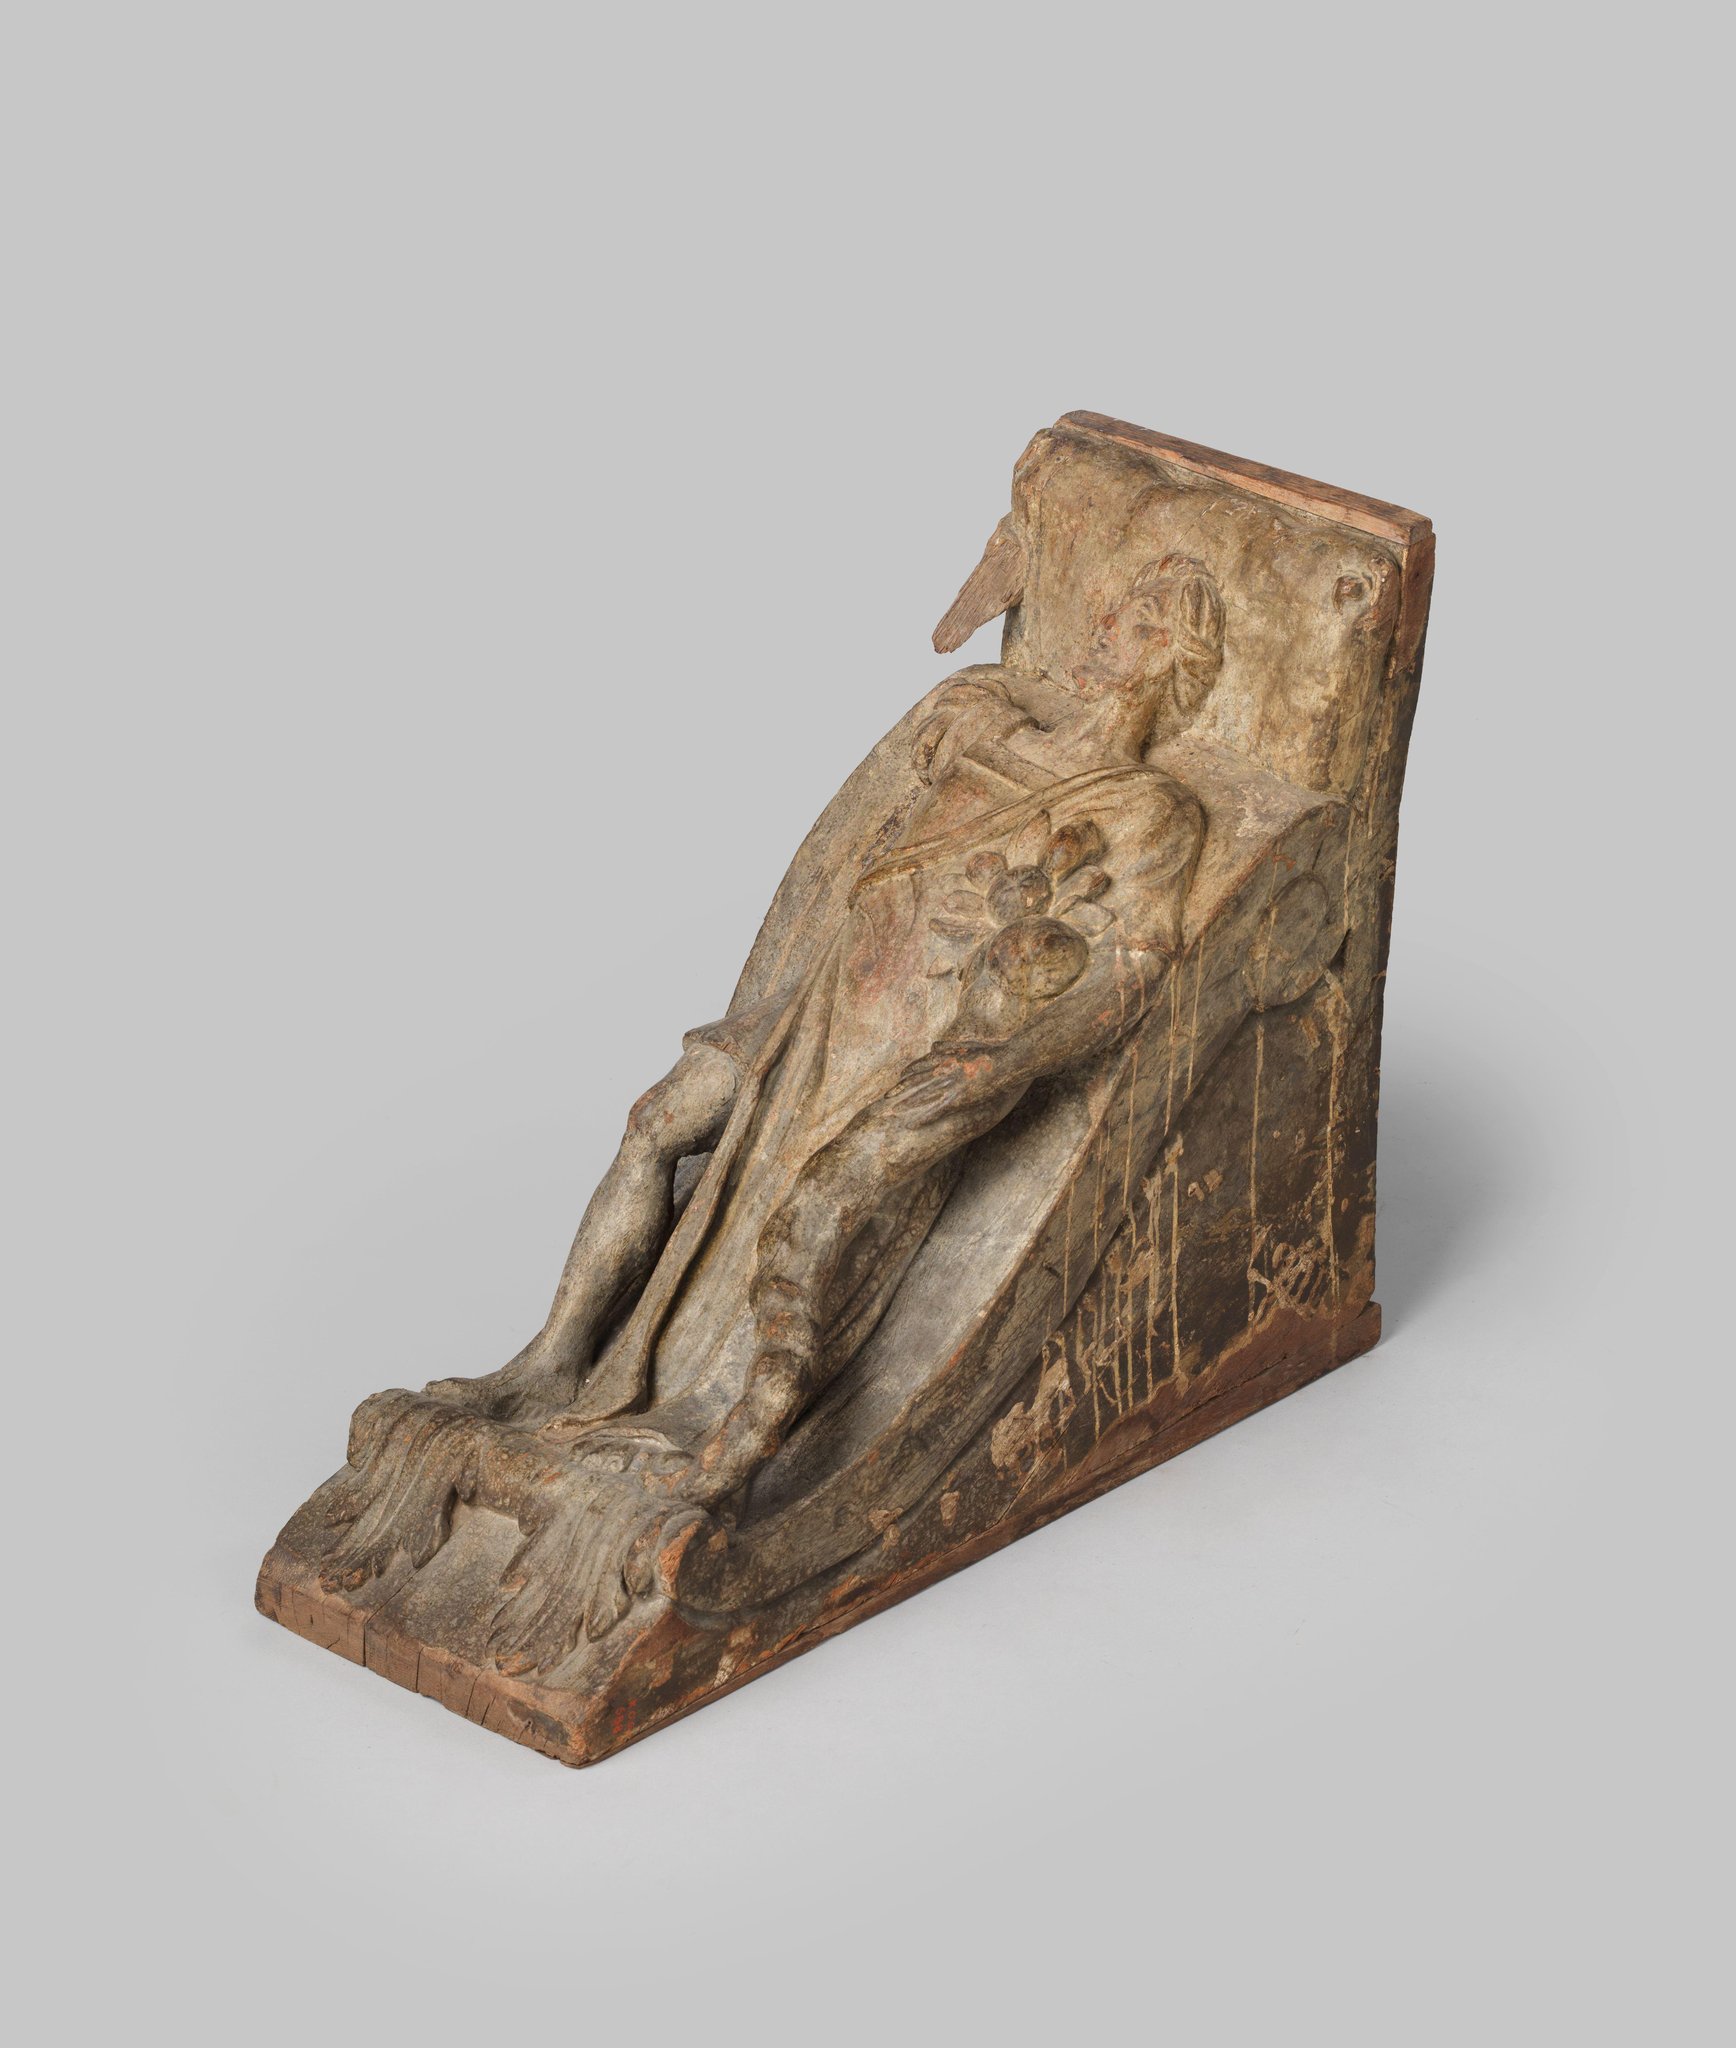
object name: korbeel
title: Bouwfragment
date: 1550-1599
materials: wood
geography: northern netherlands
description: Korbeel van eikenhout. Op het consolevormige voorstuk is in reliëf een man in een gedrapeerd gewaad en met een hoorn des overvloeds, staande op een acanthusblad, gebeeldhouwd. Afkomstig van een huis in de Mandenmakerssteeg te Amsterdam.